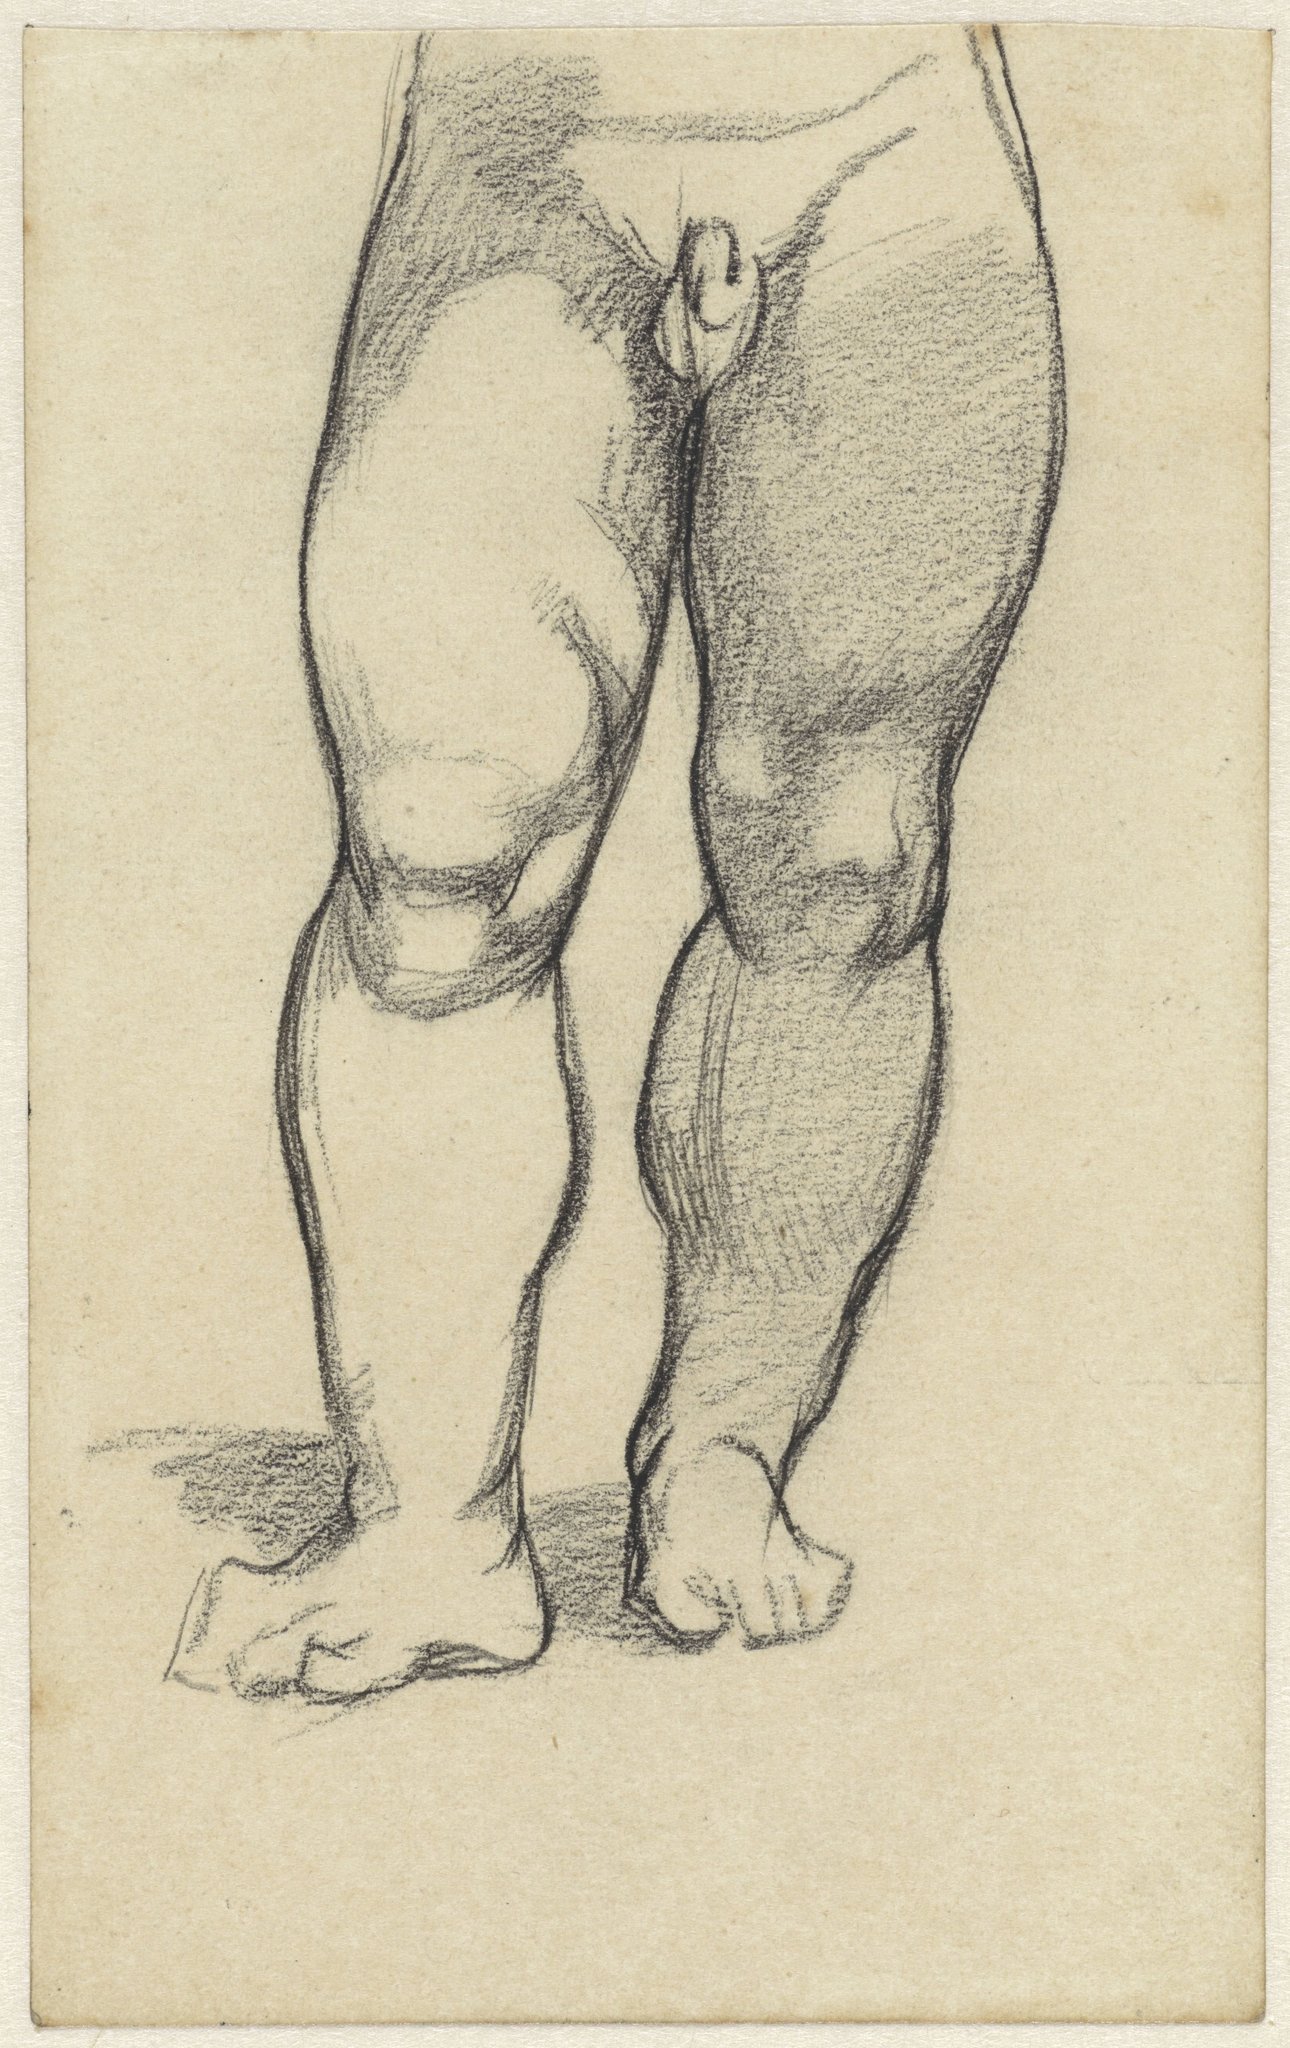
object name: drawing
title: Onderlichaam van naakt jongetje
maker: jac van looij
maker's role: draughtsman, painter, print maker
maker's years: 1855-1930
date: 1865-1930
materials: chalk, paper